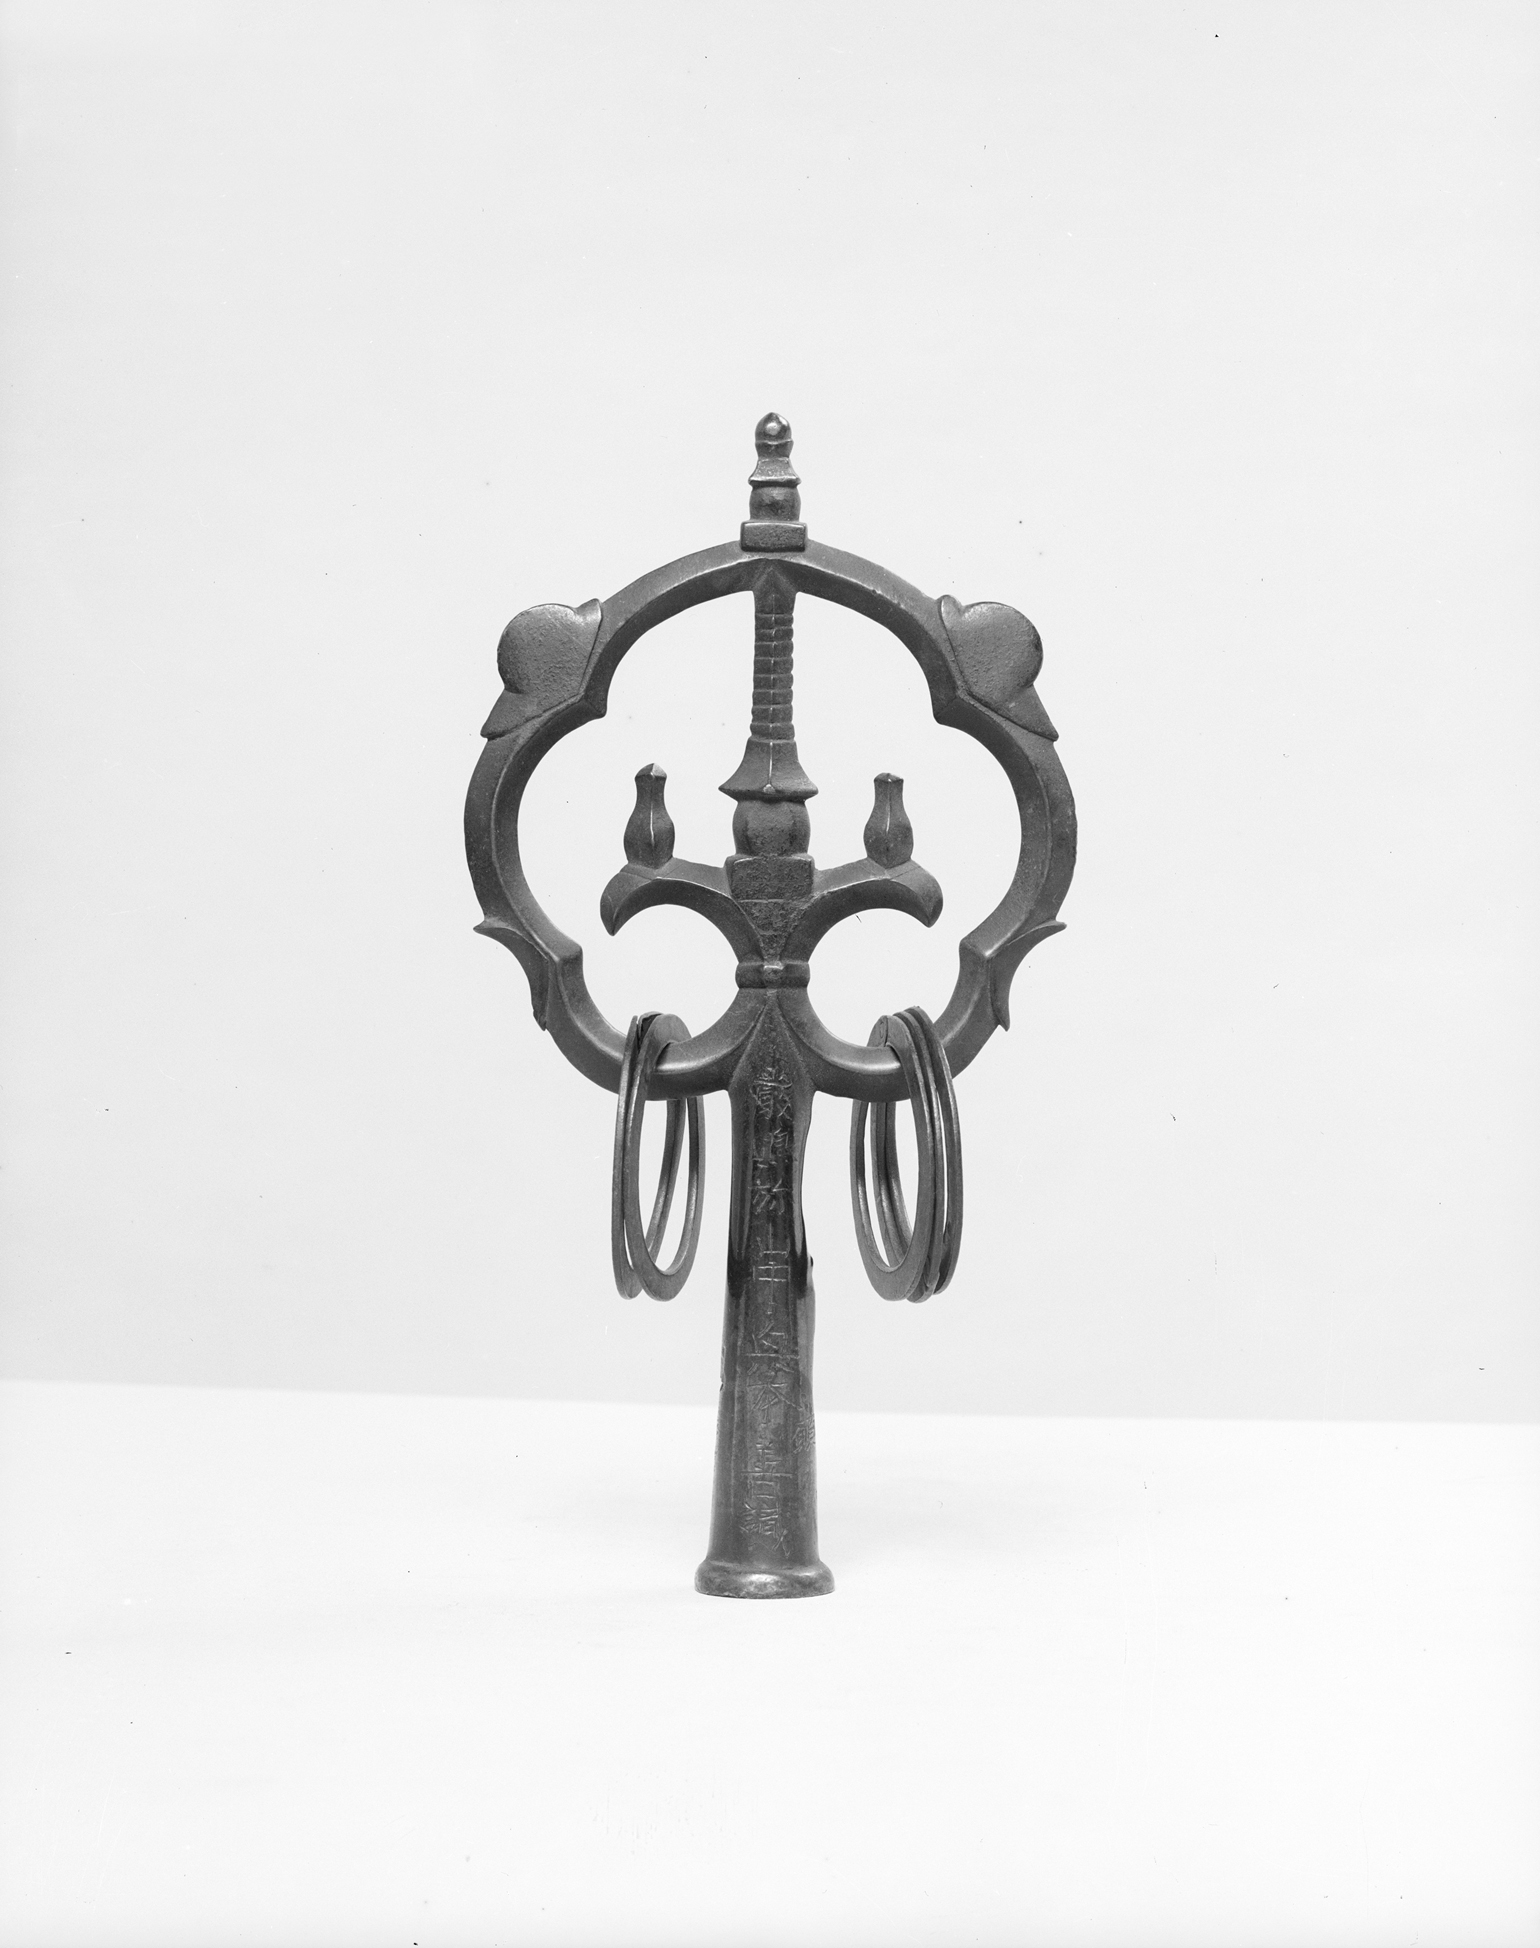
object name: staff finial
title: Finial of a Buddhist Monk’s Staff (Shakujō)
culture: japanese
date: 1615-1898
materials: bronze